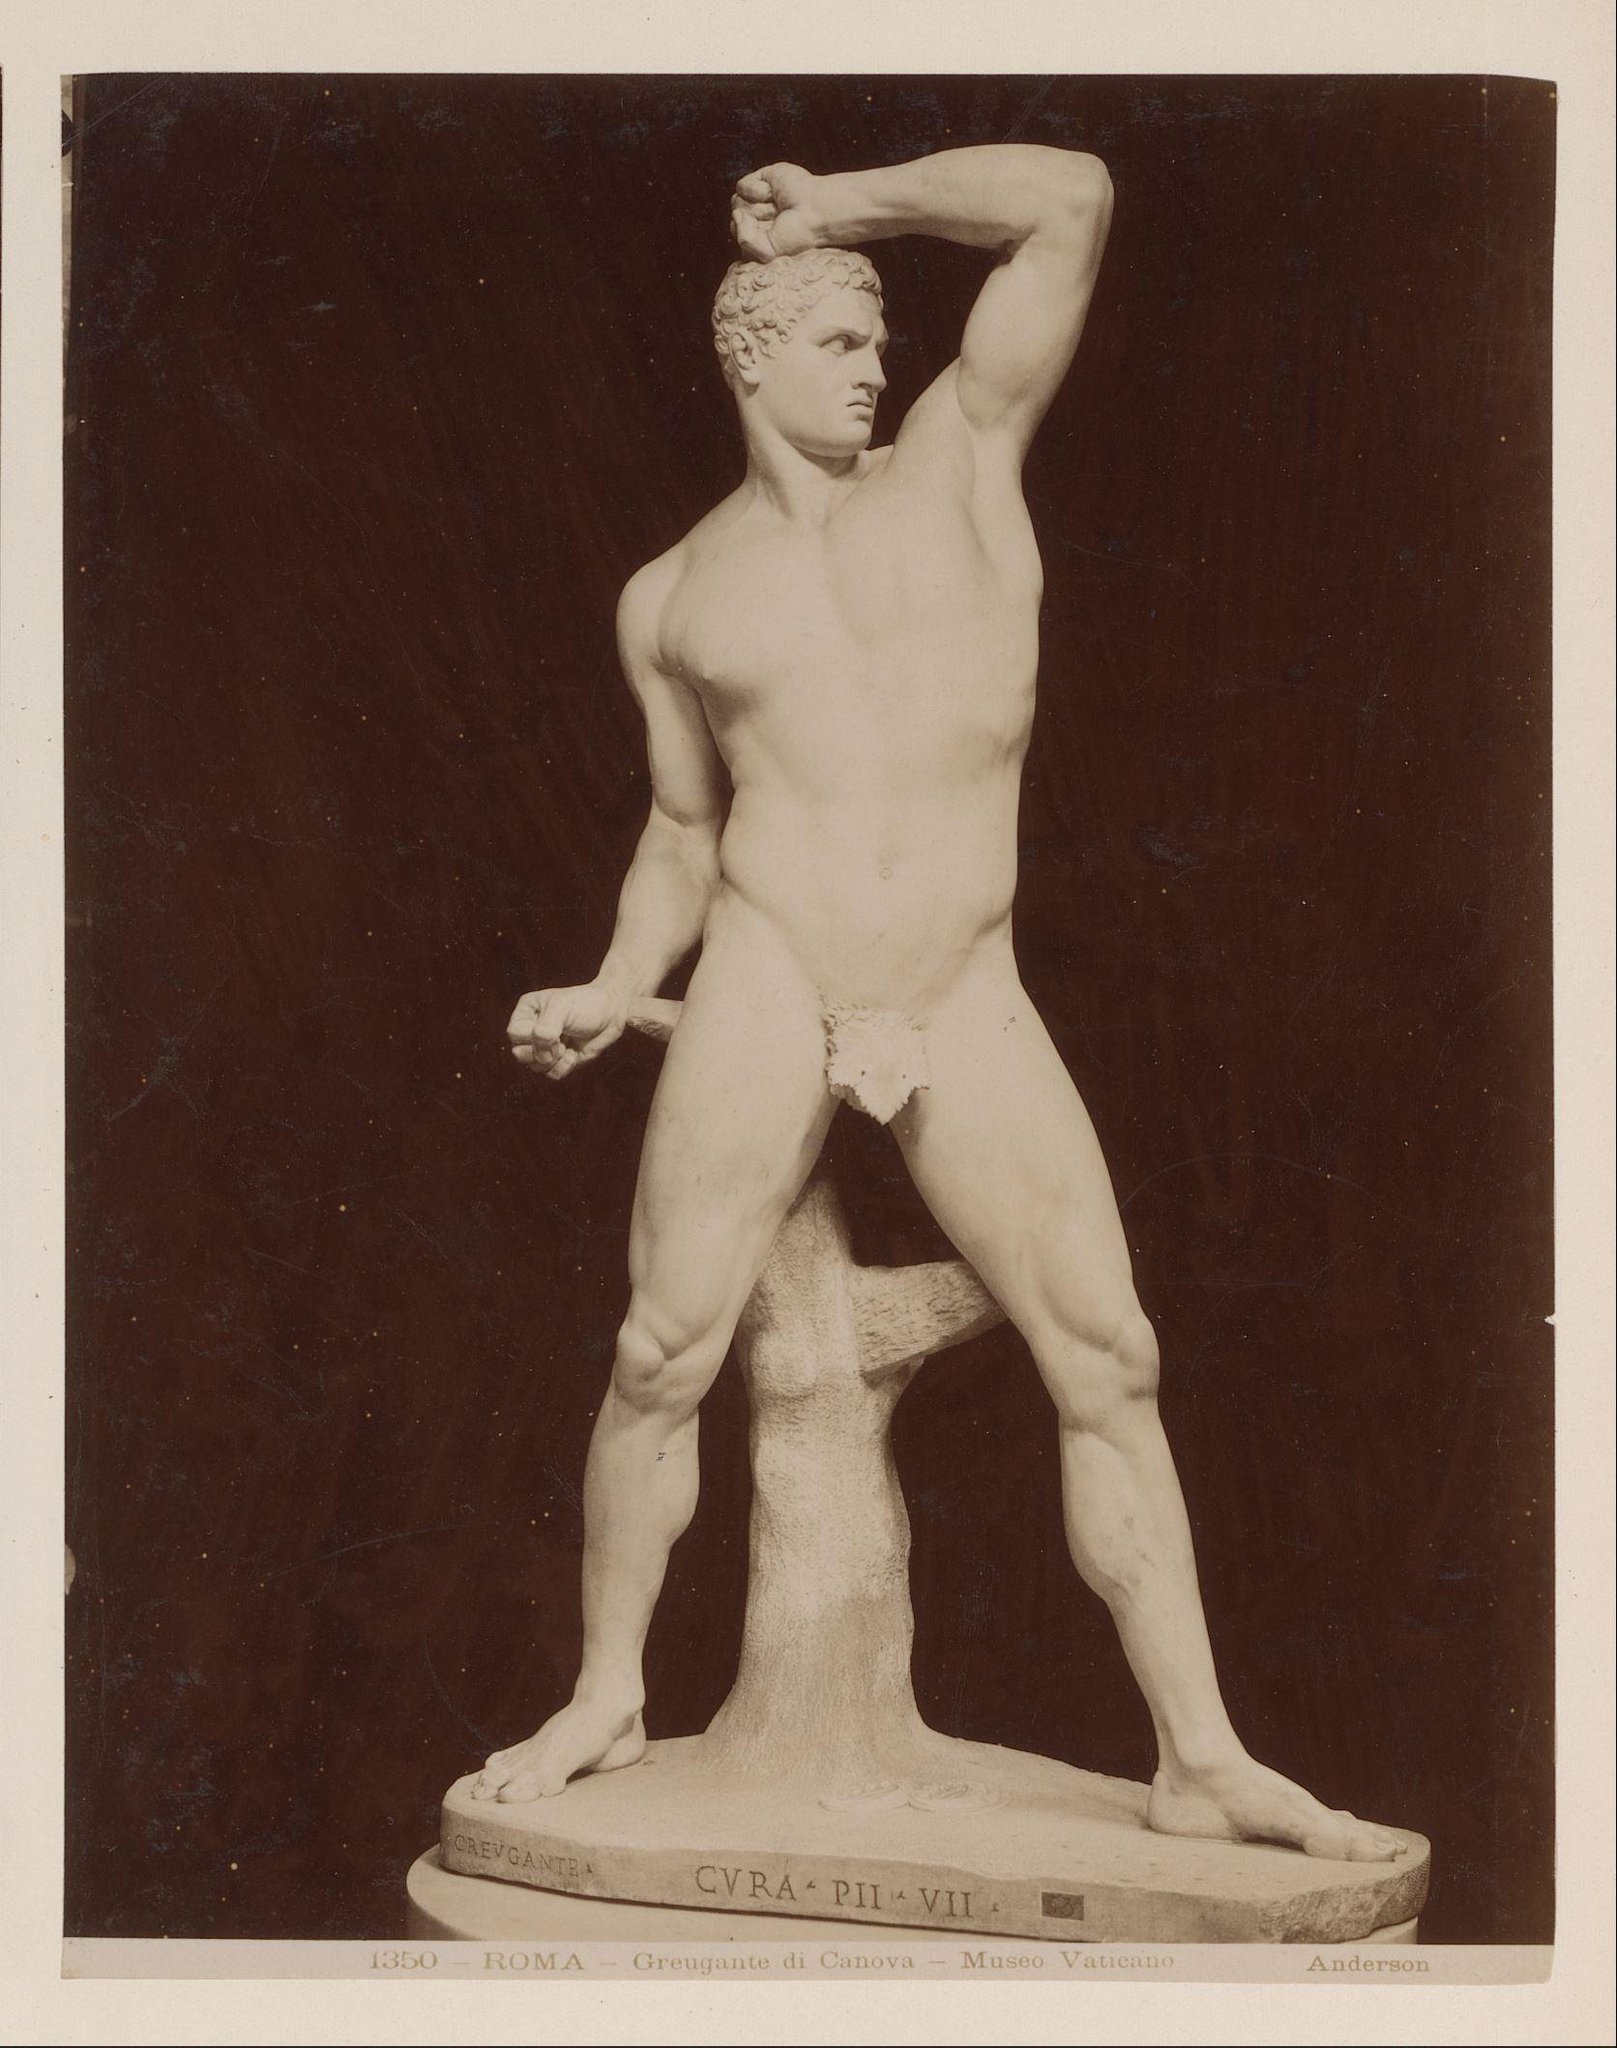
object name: album leaf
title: Sculptuur van Creugas, Vaticaan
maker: james anderson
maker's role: fotograaf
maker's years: 1813-1877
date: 1857-1875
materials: paper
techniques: albumen print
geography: vatican museums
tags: piece of sculpture, reproduction of a piece of sculpture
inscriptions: inscription: ‘1350 - ROMA - Greugante di Canova - Museo Vaticano Anderson’